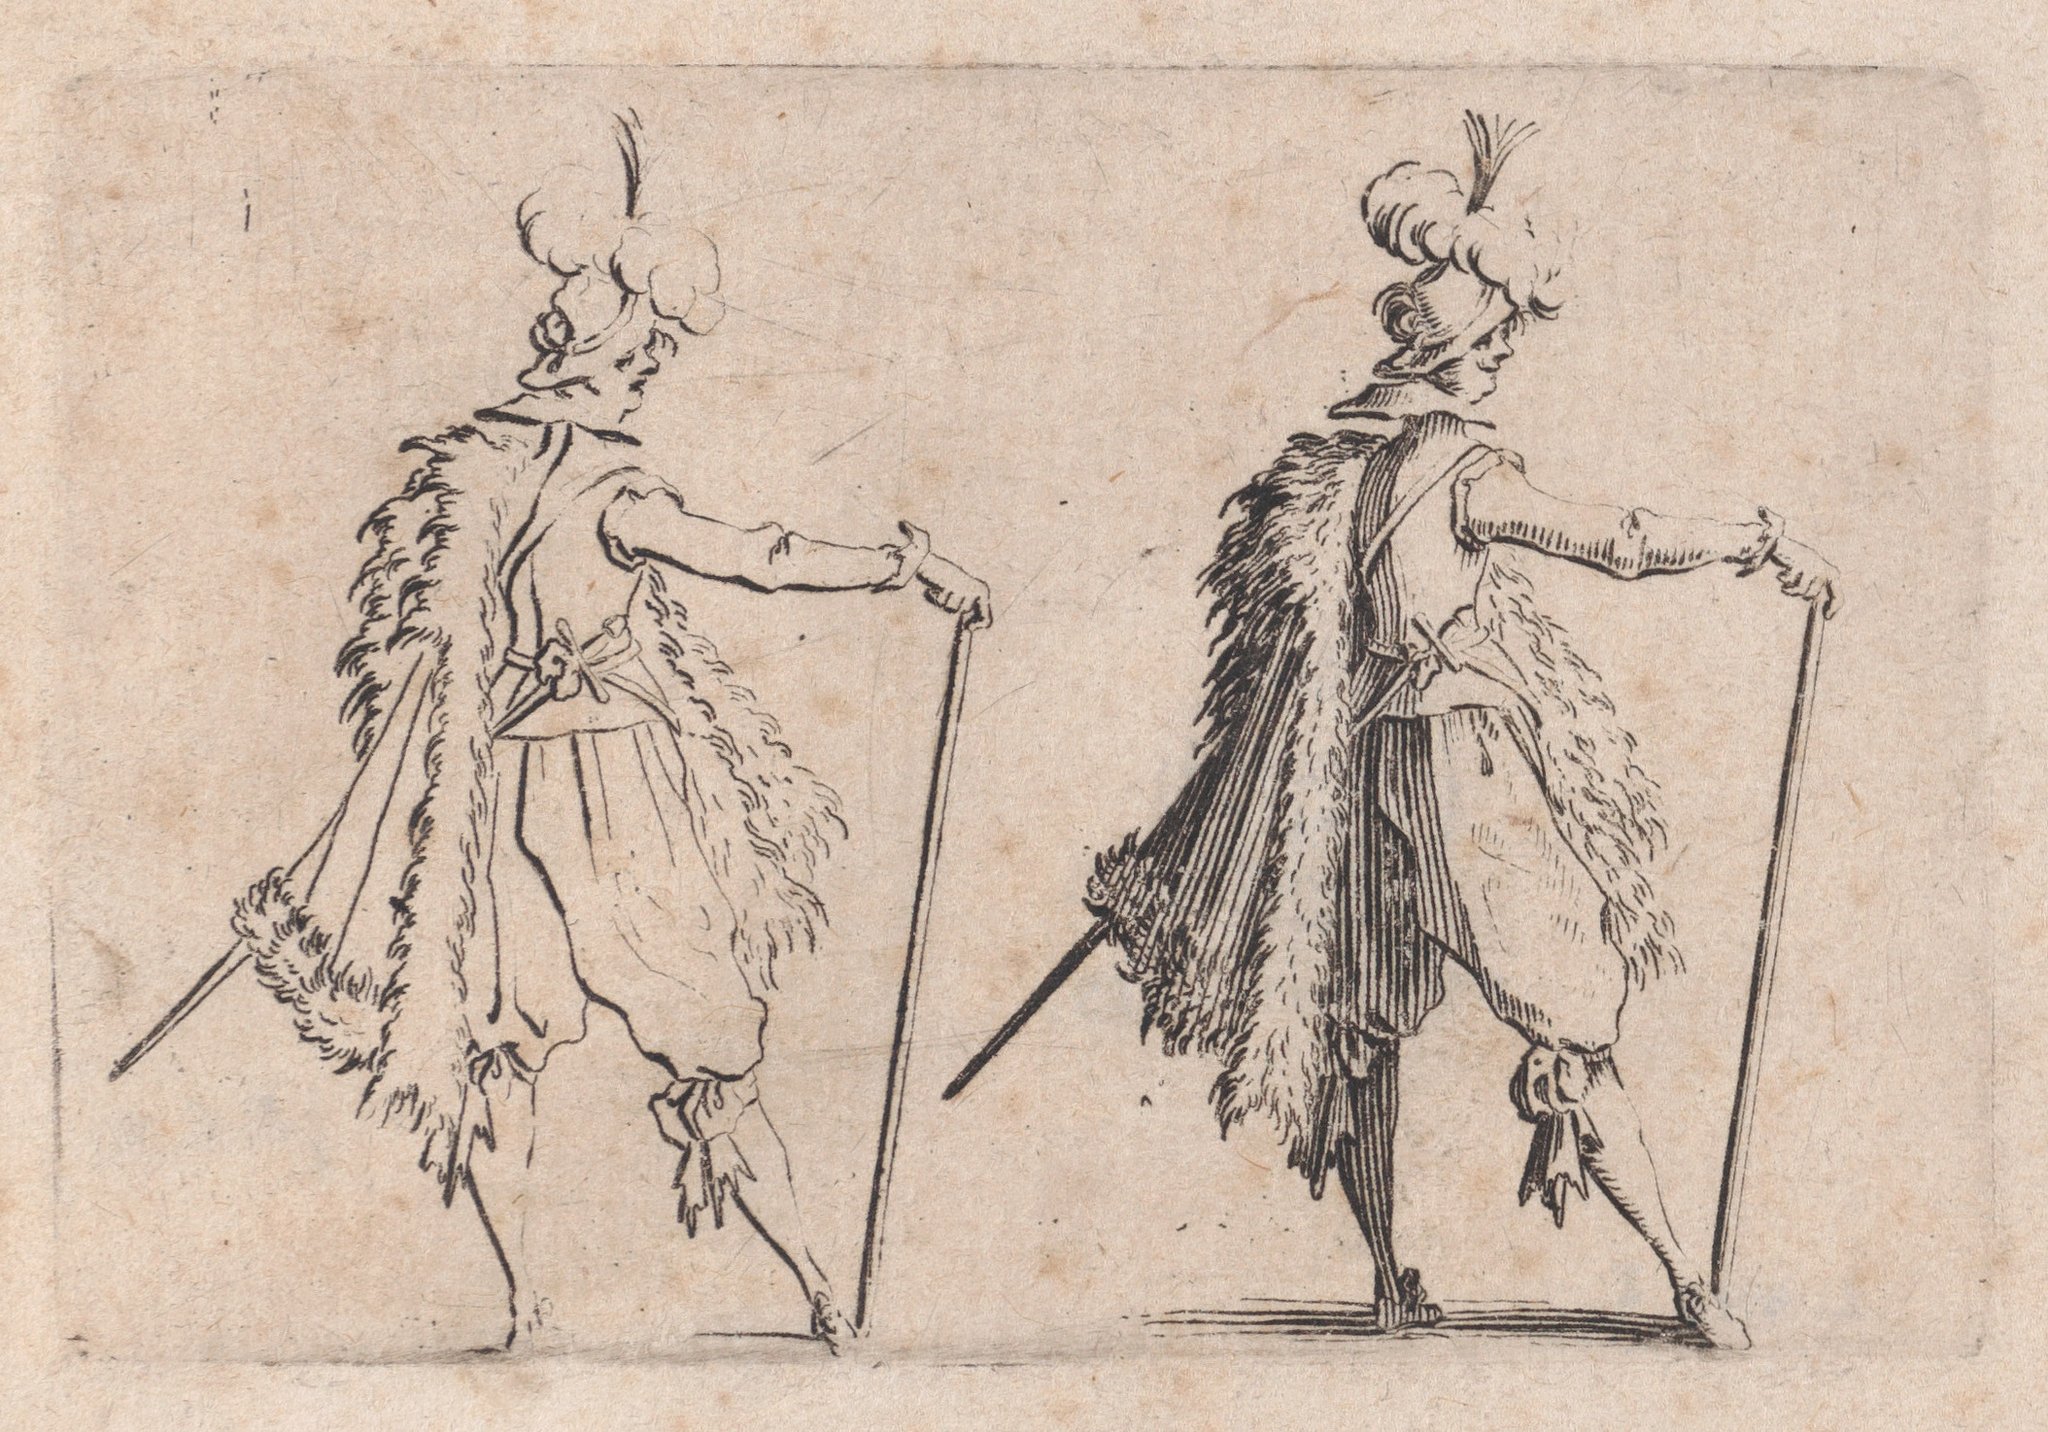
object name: print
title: Le Gentilhomme a la Grande Canne (The Gentleman with a Large Cane), from "Les Caprices" Series B, The Nancy Set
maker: jacques callot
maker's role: artist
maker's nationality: french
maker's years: 1592-1635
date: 1617-1620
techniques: etching